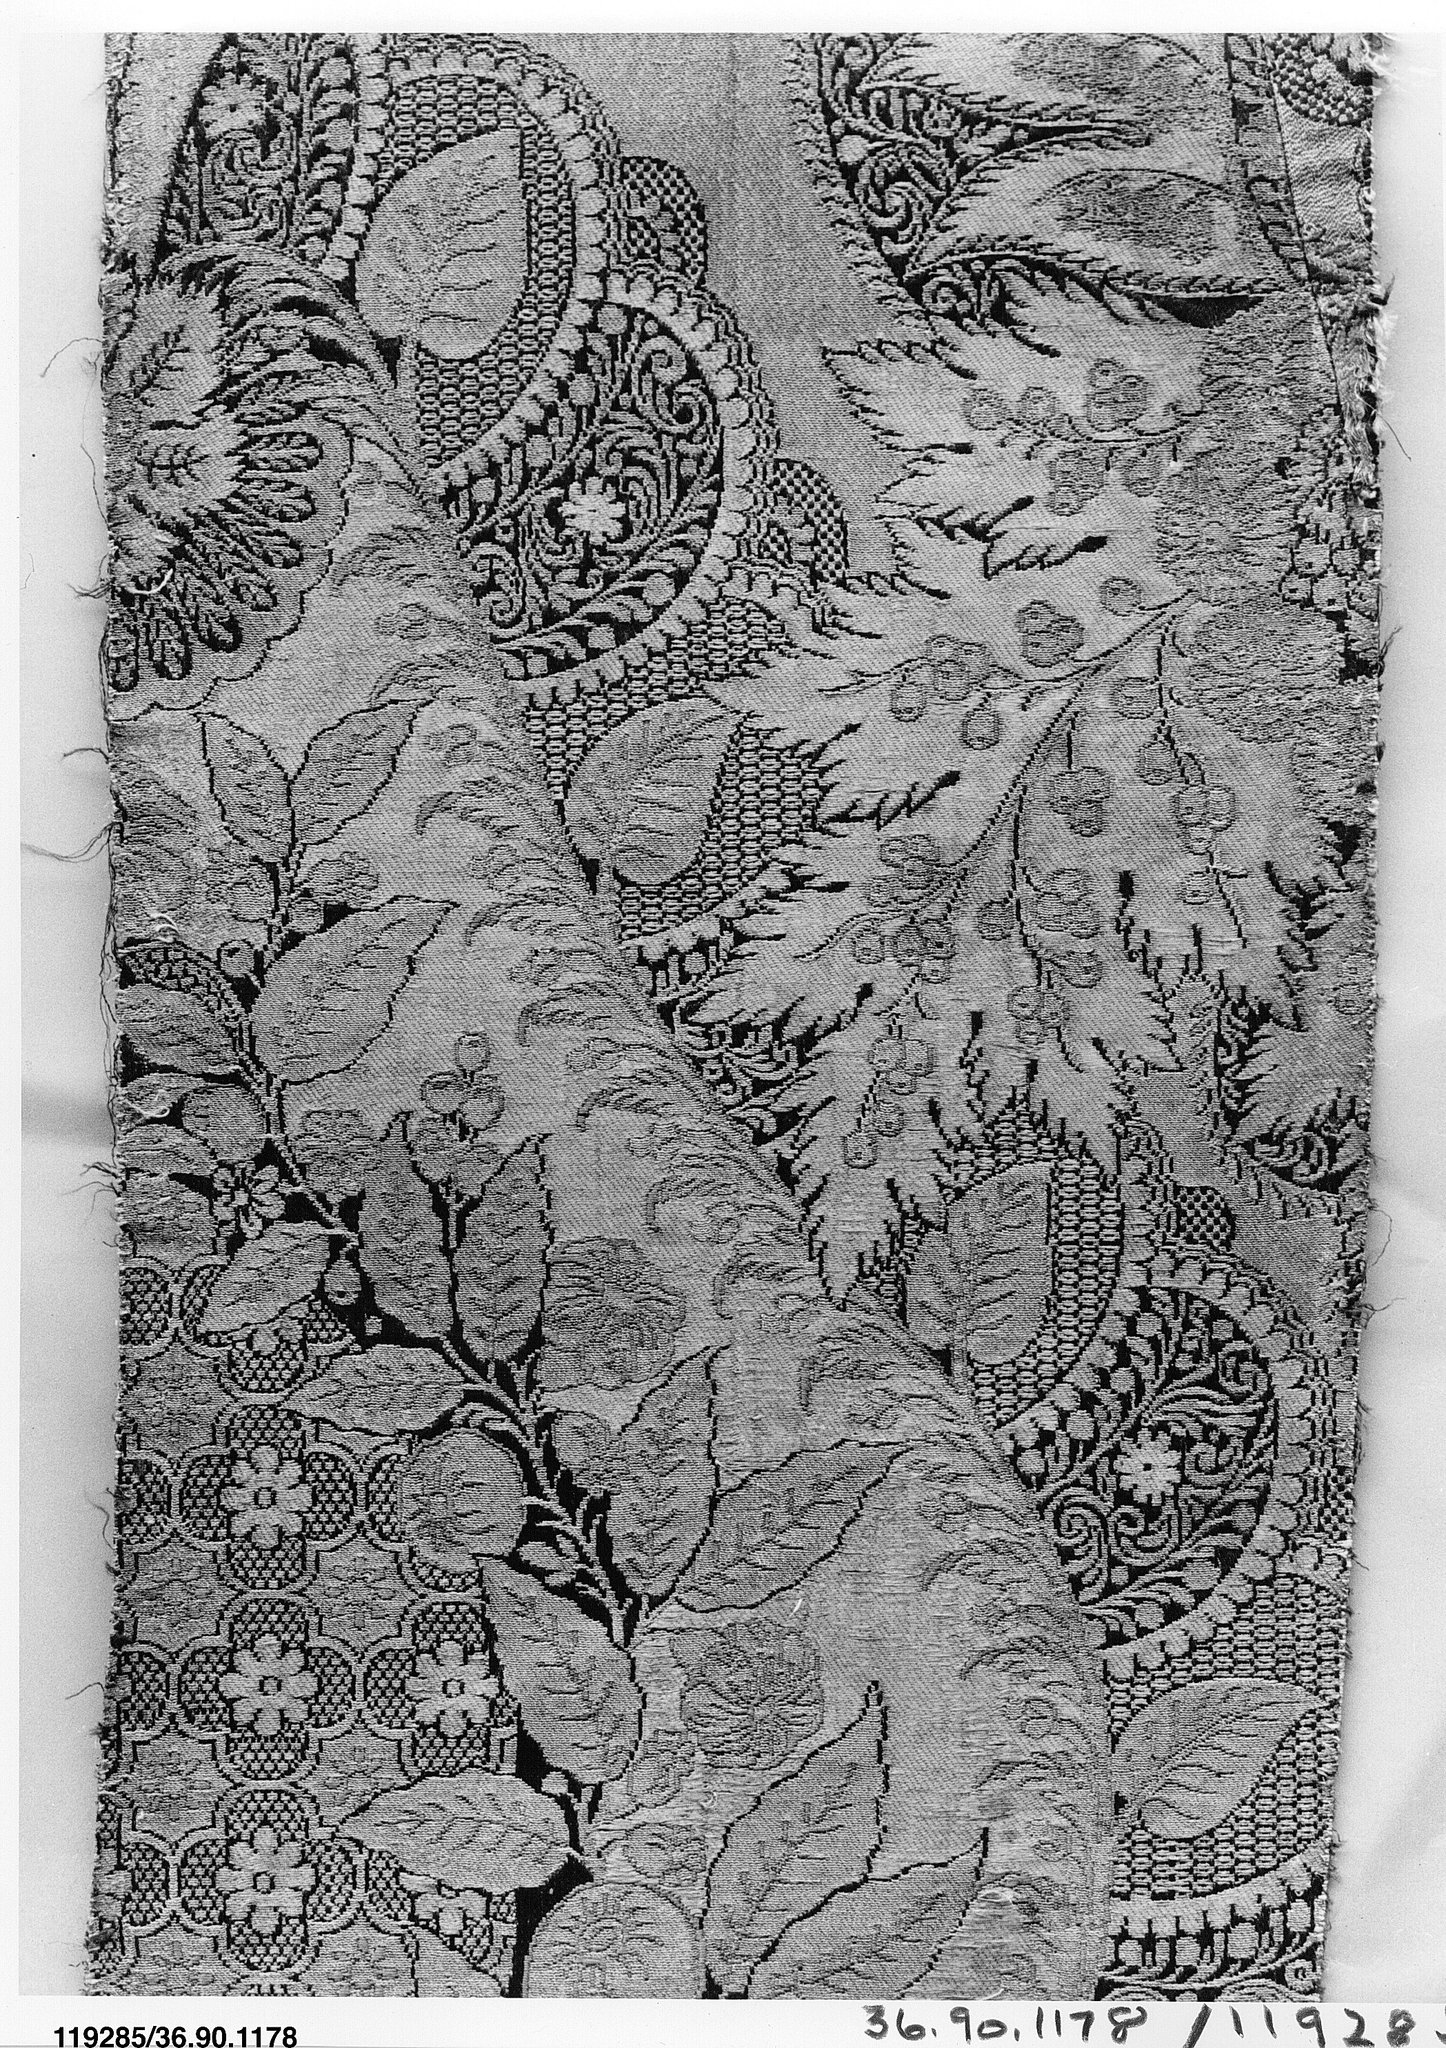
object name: piece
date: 1725-1730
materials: metal thread, silk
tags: flowers,leaves